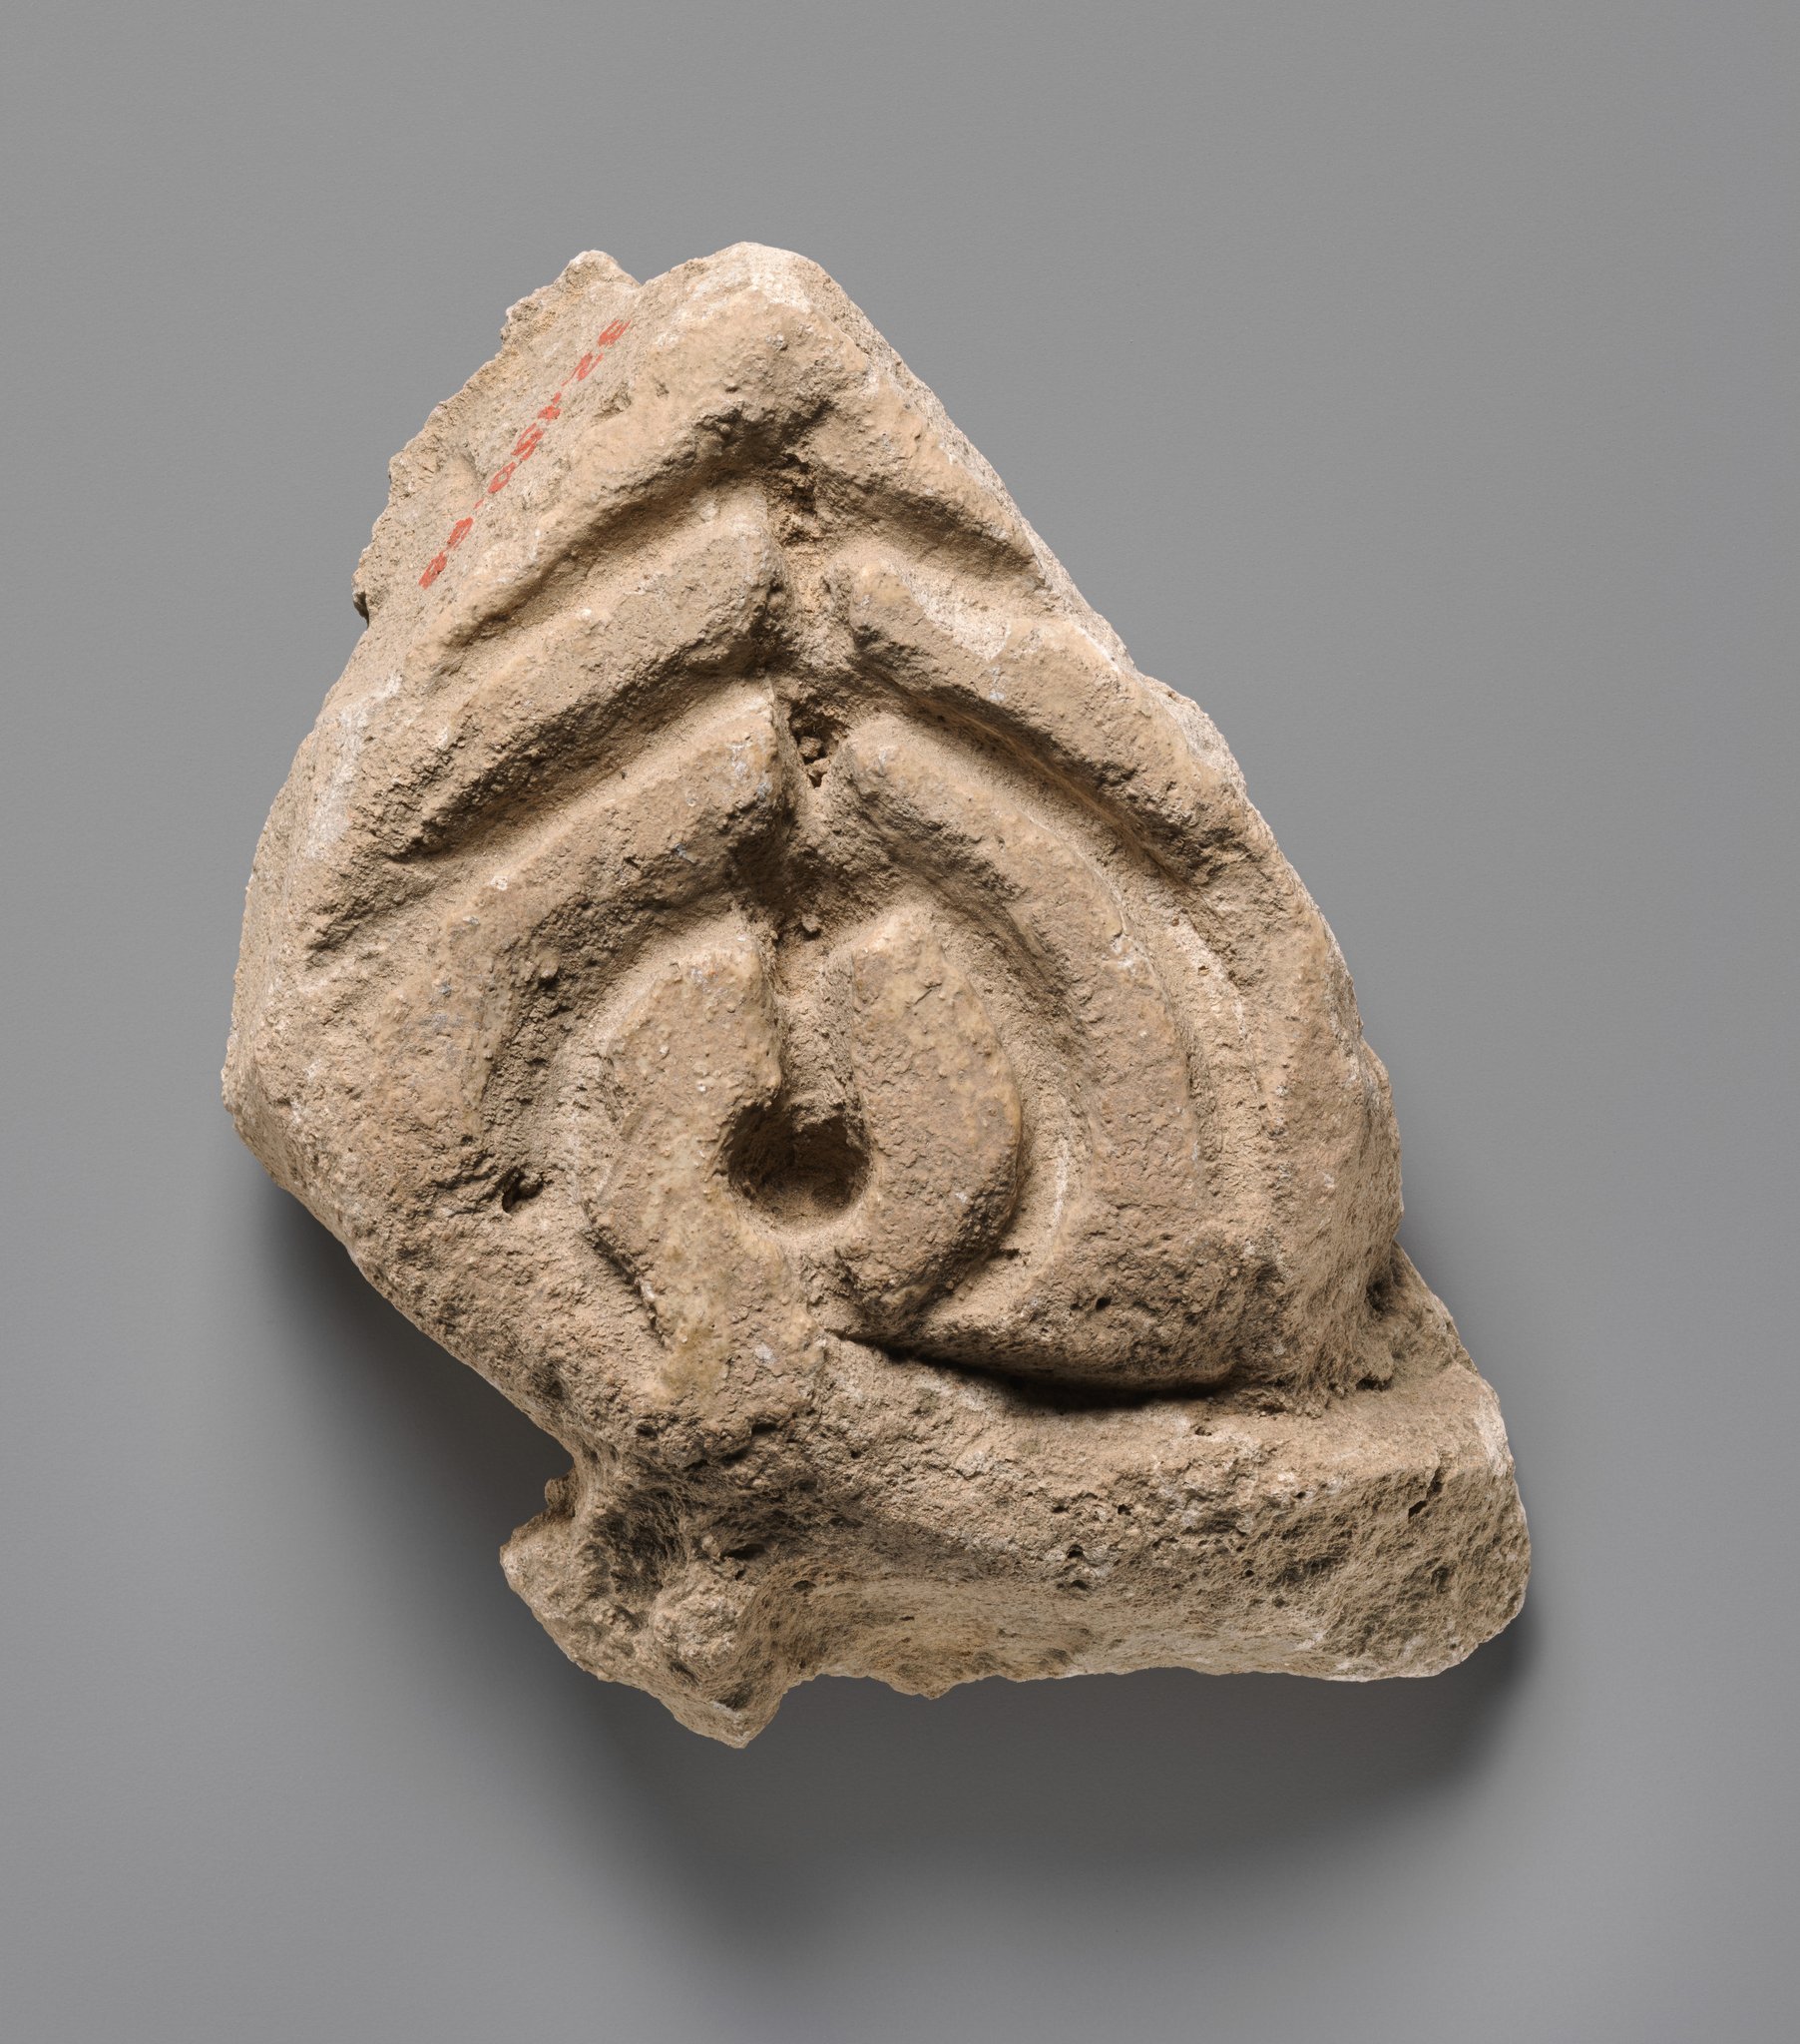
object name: relief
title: Relief fragment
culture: sasanian or islamic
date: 501-800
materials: plaster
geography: mesopotamia